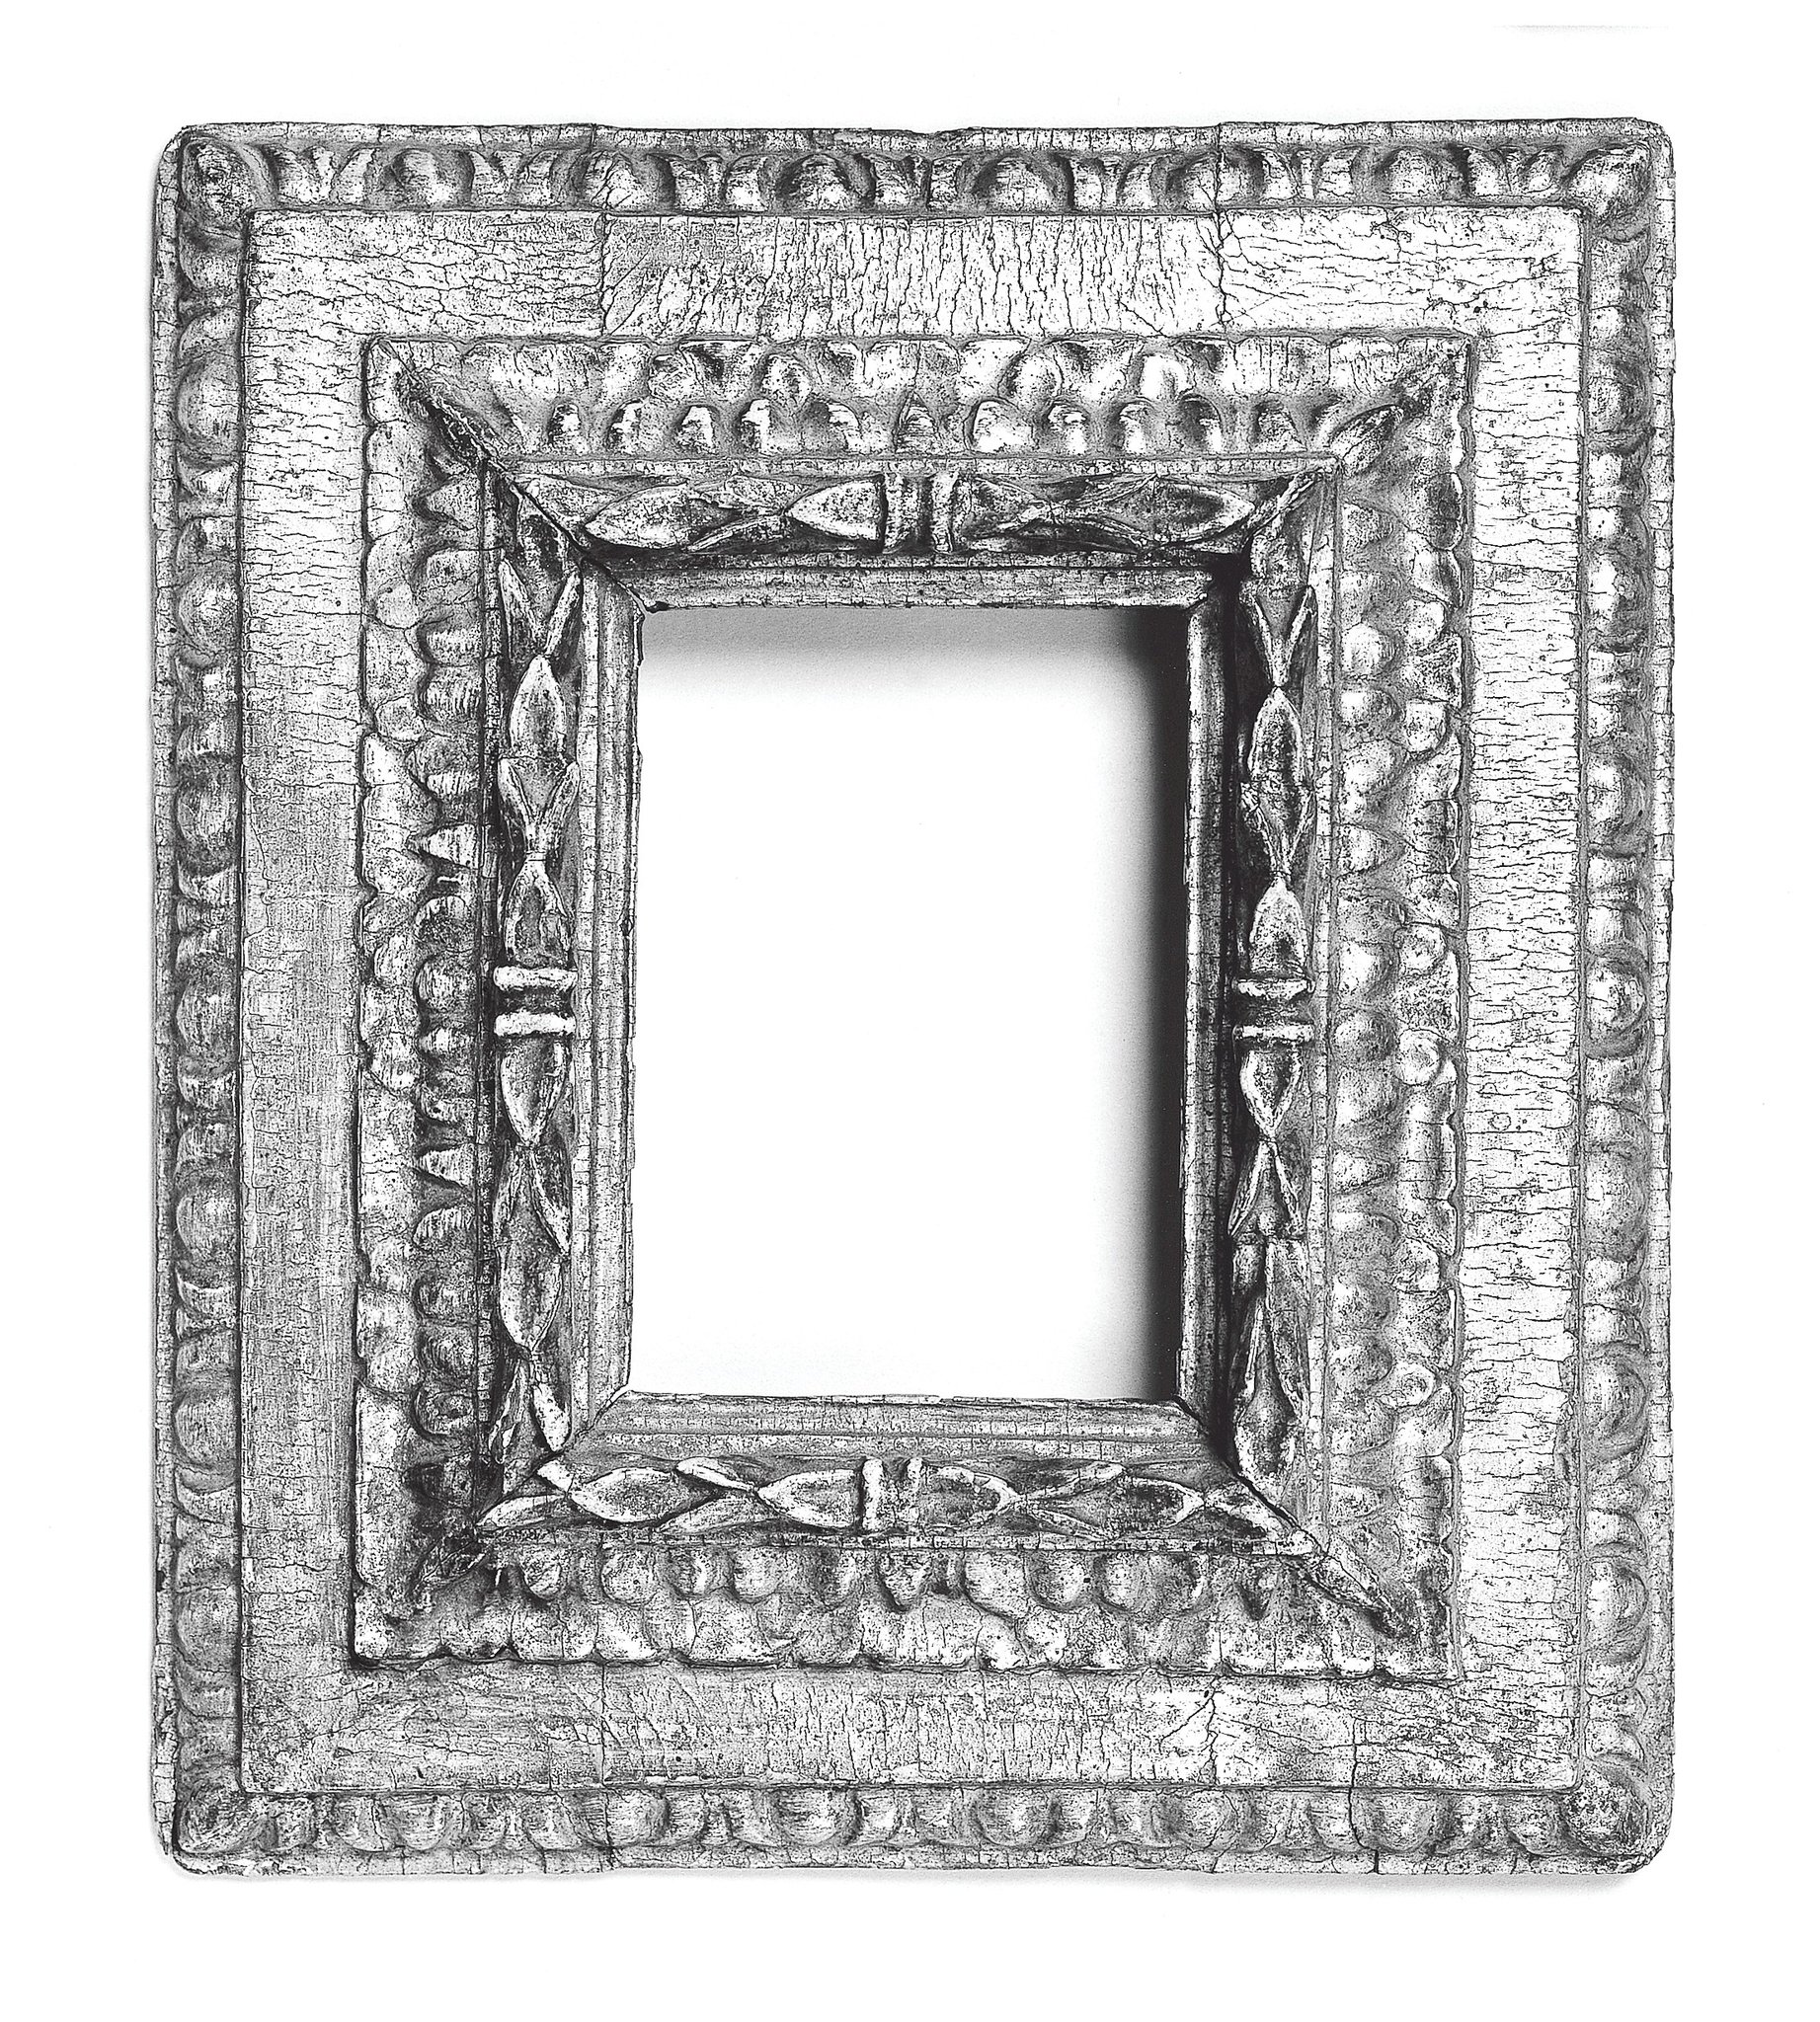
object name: frame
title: Reverse frame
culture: italian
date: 1640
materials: wood